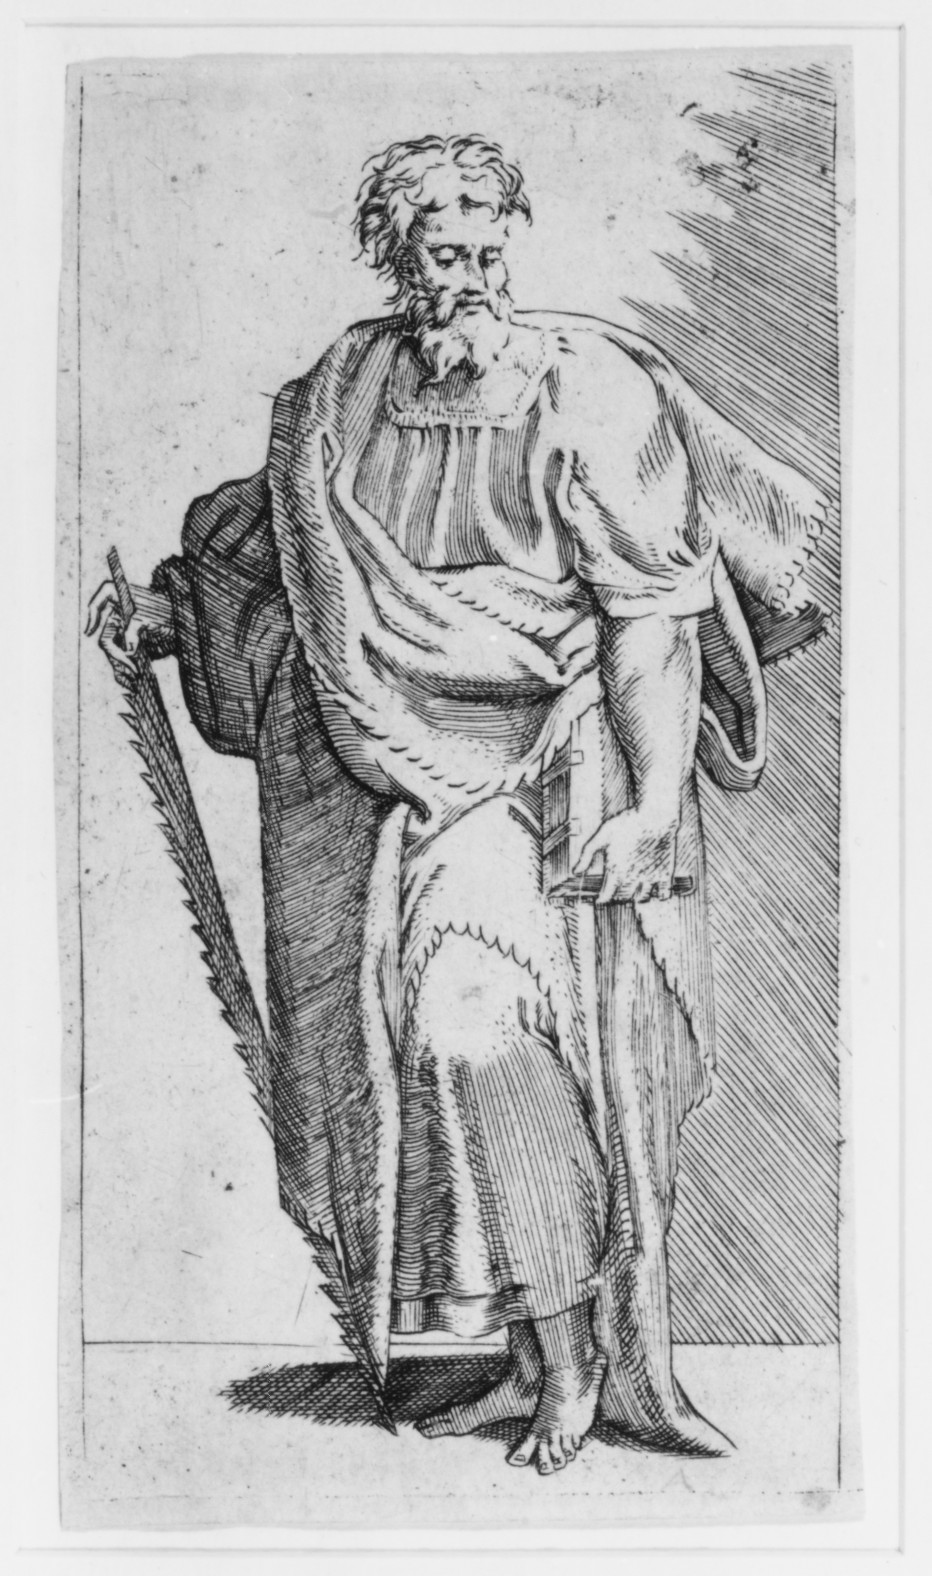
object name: print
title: Saint Simon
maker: angiolo falconetto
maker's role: artist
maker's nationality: italian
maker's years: 1555-1567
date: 1555-1567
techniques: etching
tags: men,saints